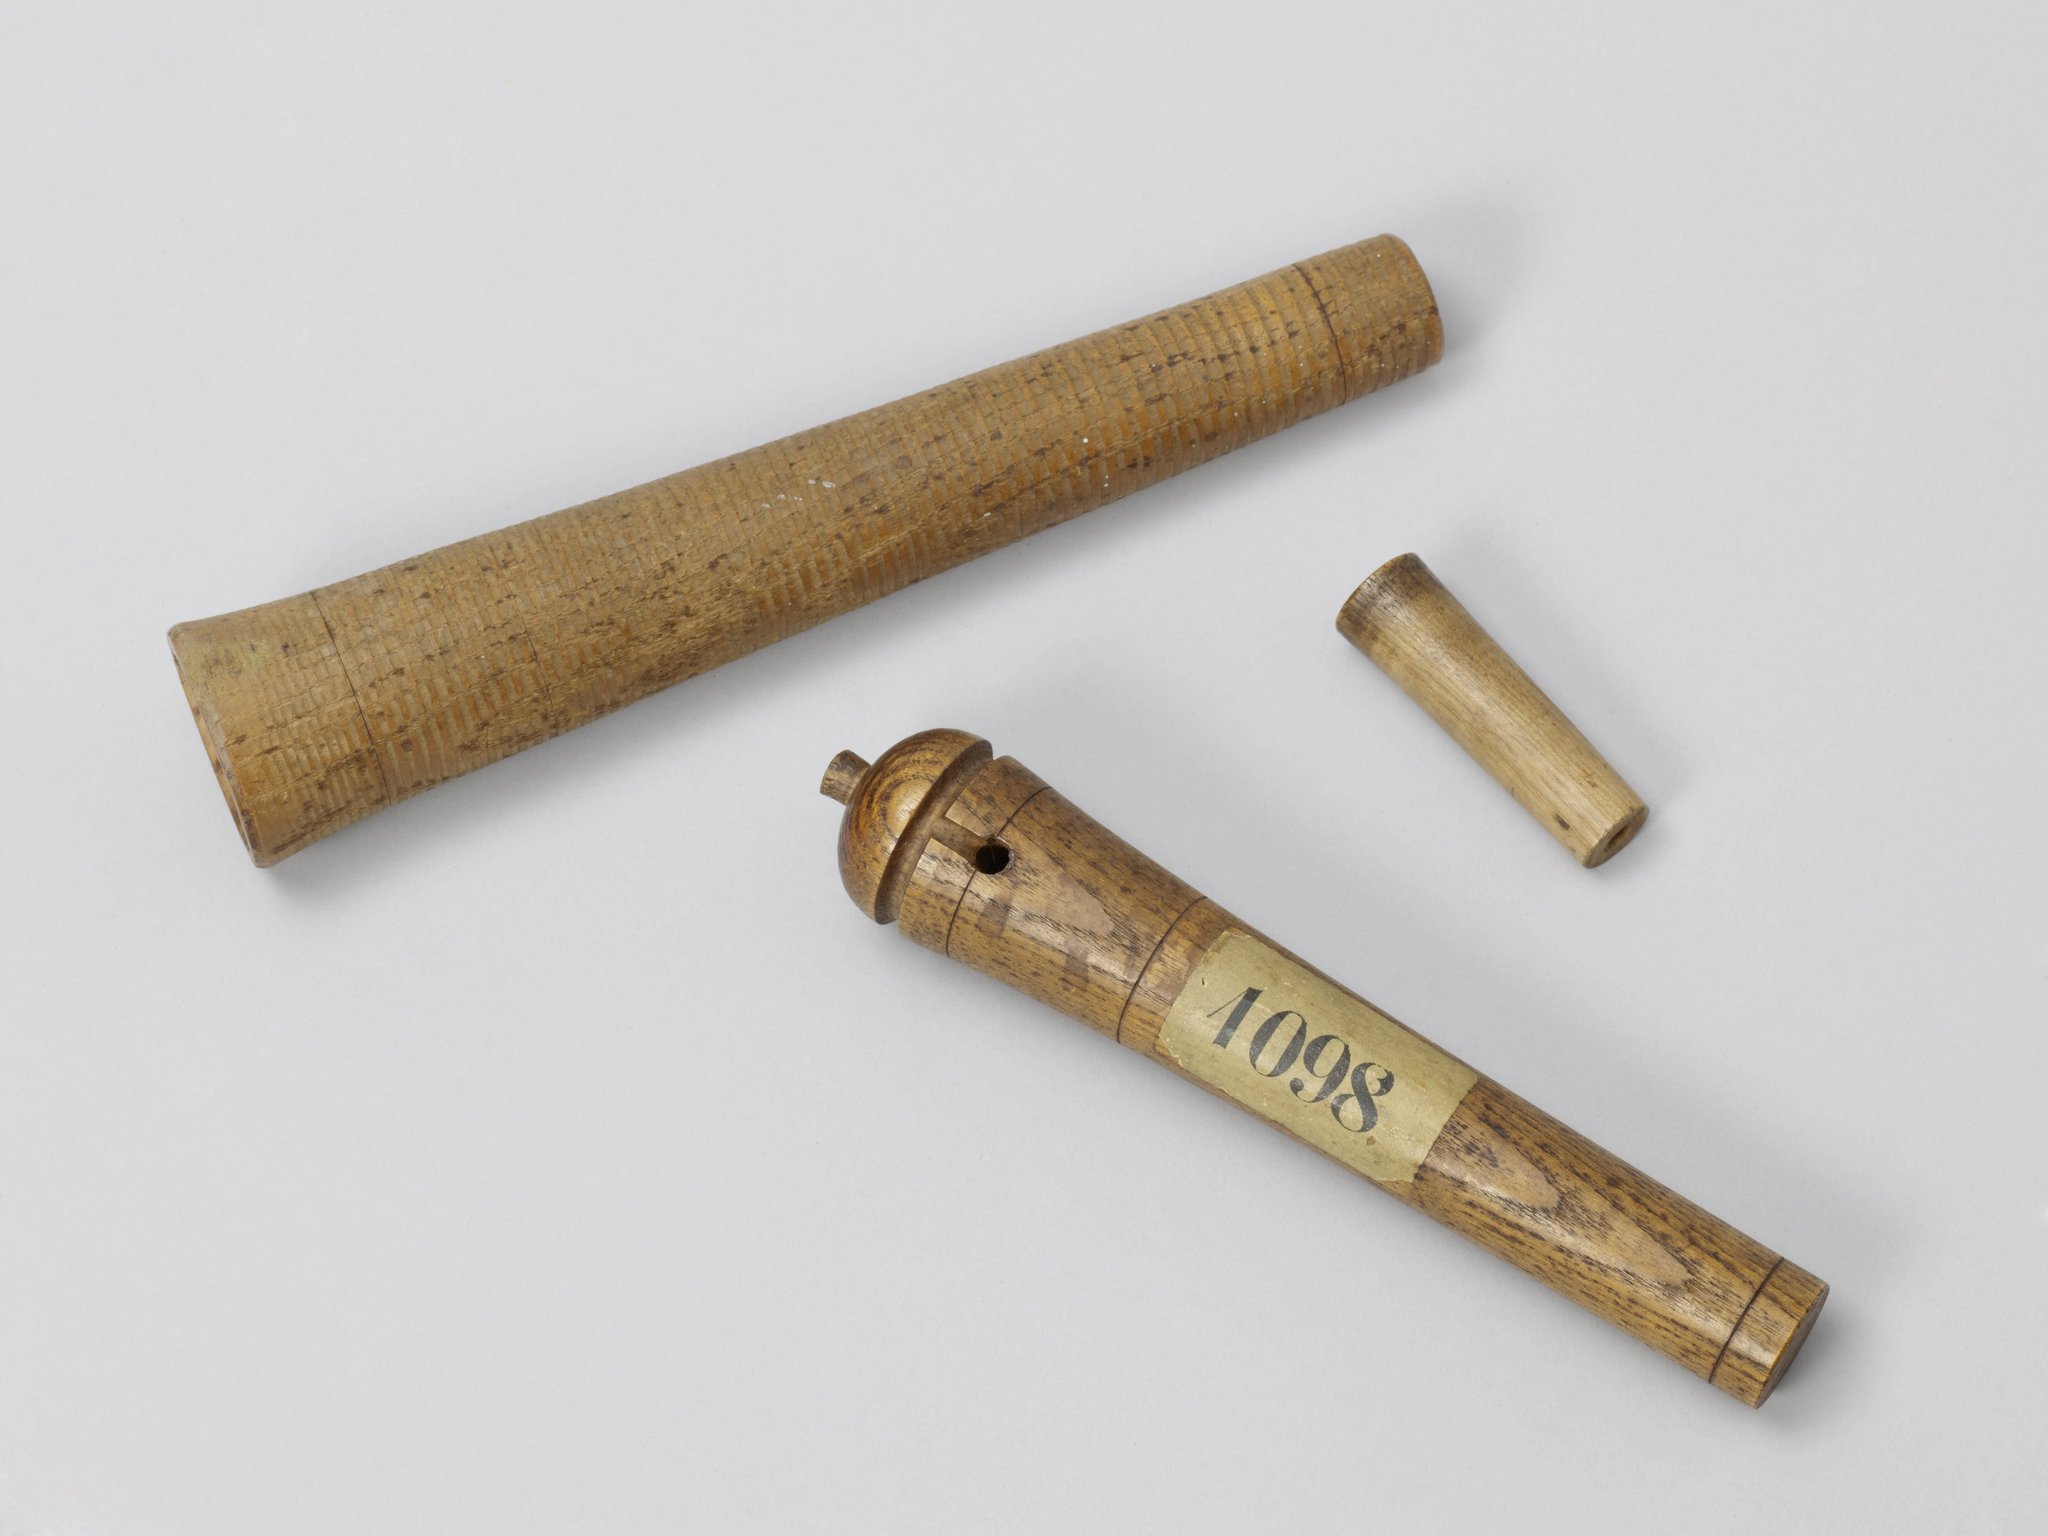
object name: demonstration model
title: Three Models of Fuses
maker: Anonymous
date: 1850-1860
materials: wood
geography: netherlands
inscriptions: label, on model B: ‘1098’ former inventory label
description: Drie modellen van houten buizen voor granaten van verschillend kaliber. Twee zijn conische houten buizen met een holle kom aan de bovenzijde, waarin de opgerolde lont werd gelegd; de lange buis van dit paar is niet helemaal doorboord. Het derde model heeft een bolle bovenzijde, afgesloten met een houten prop. Om de kop heen loopt een groef en er is een gat dwars door de buis geboord: hieruit wordt de lont naar buiten geleid en om de groef gelegd. Een vierde model, een Engelse metalen buis uit 1860, ontbreekt.